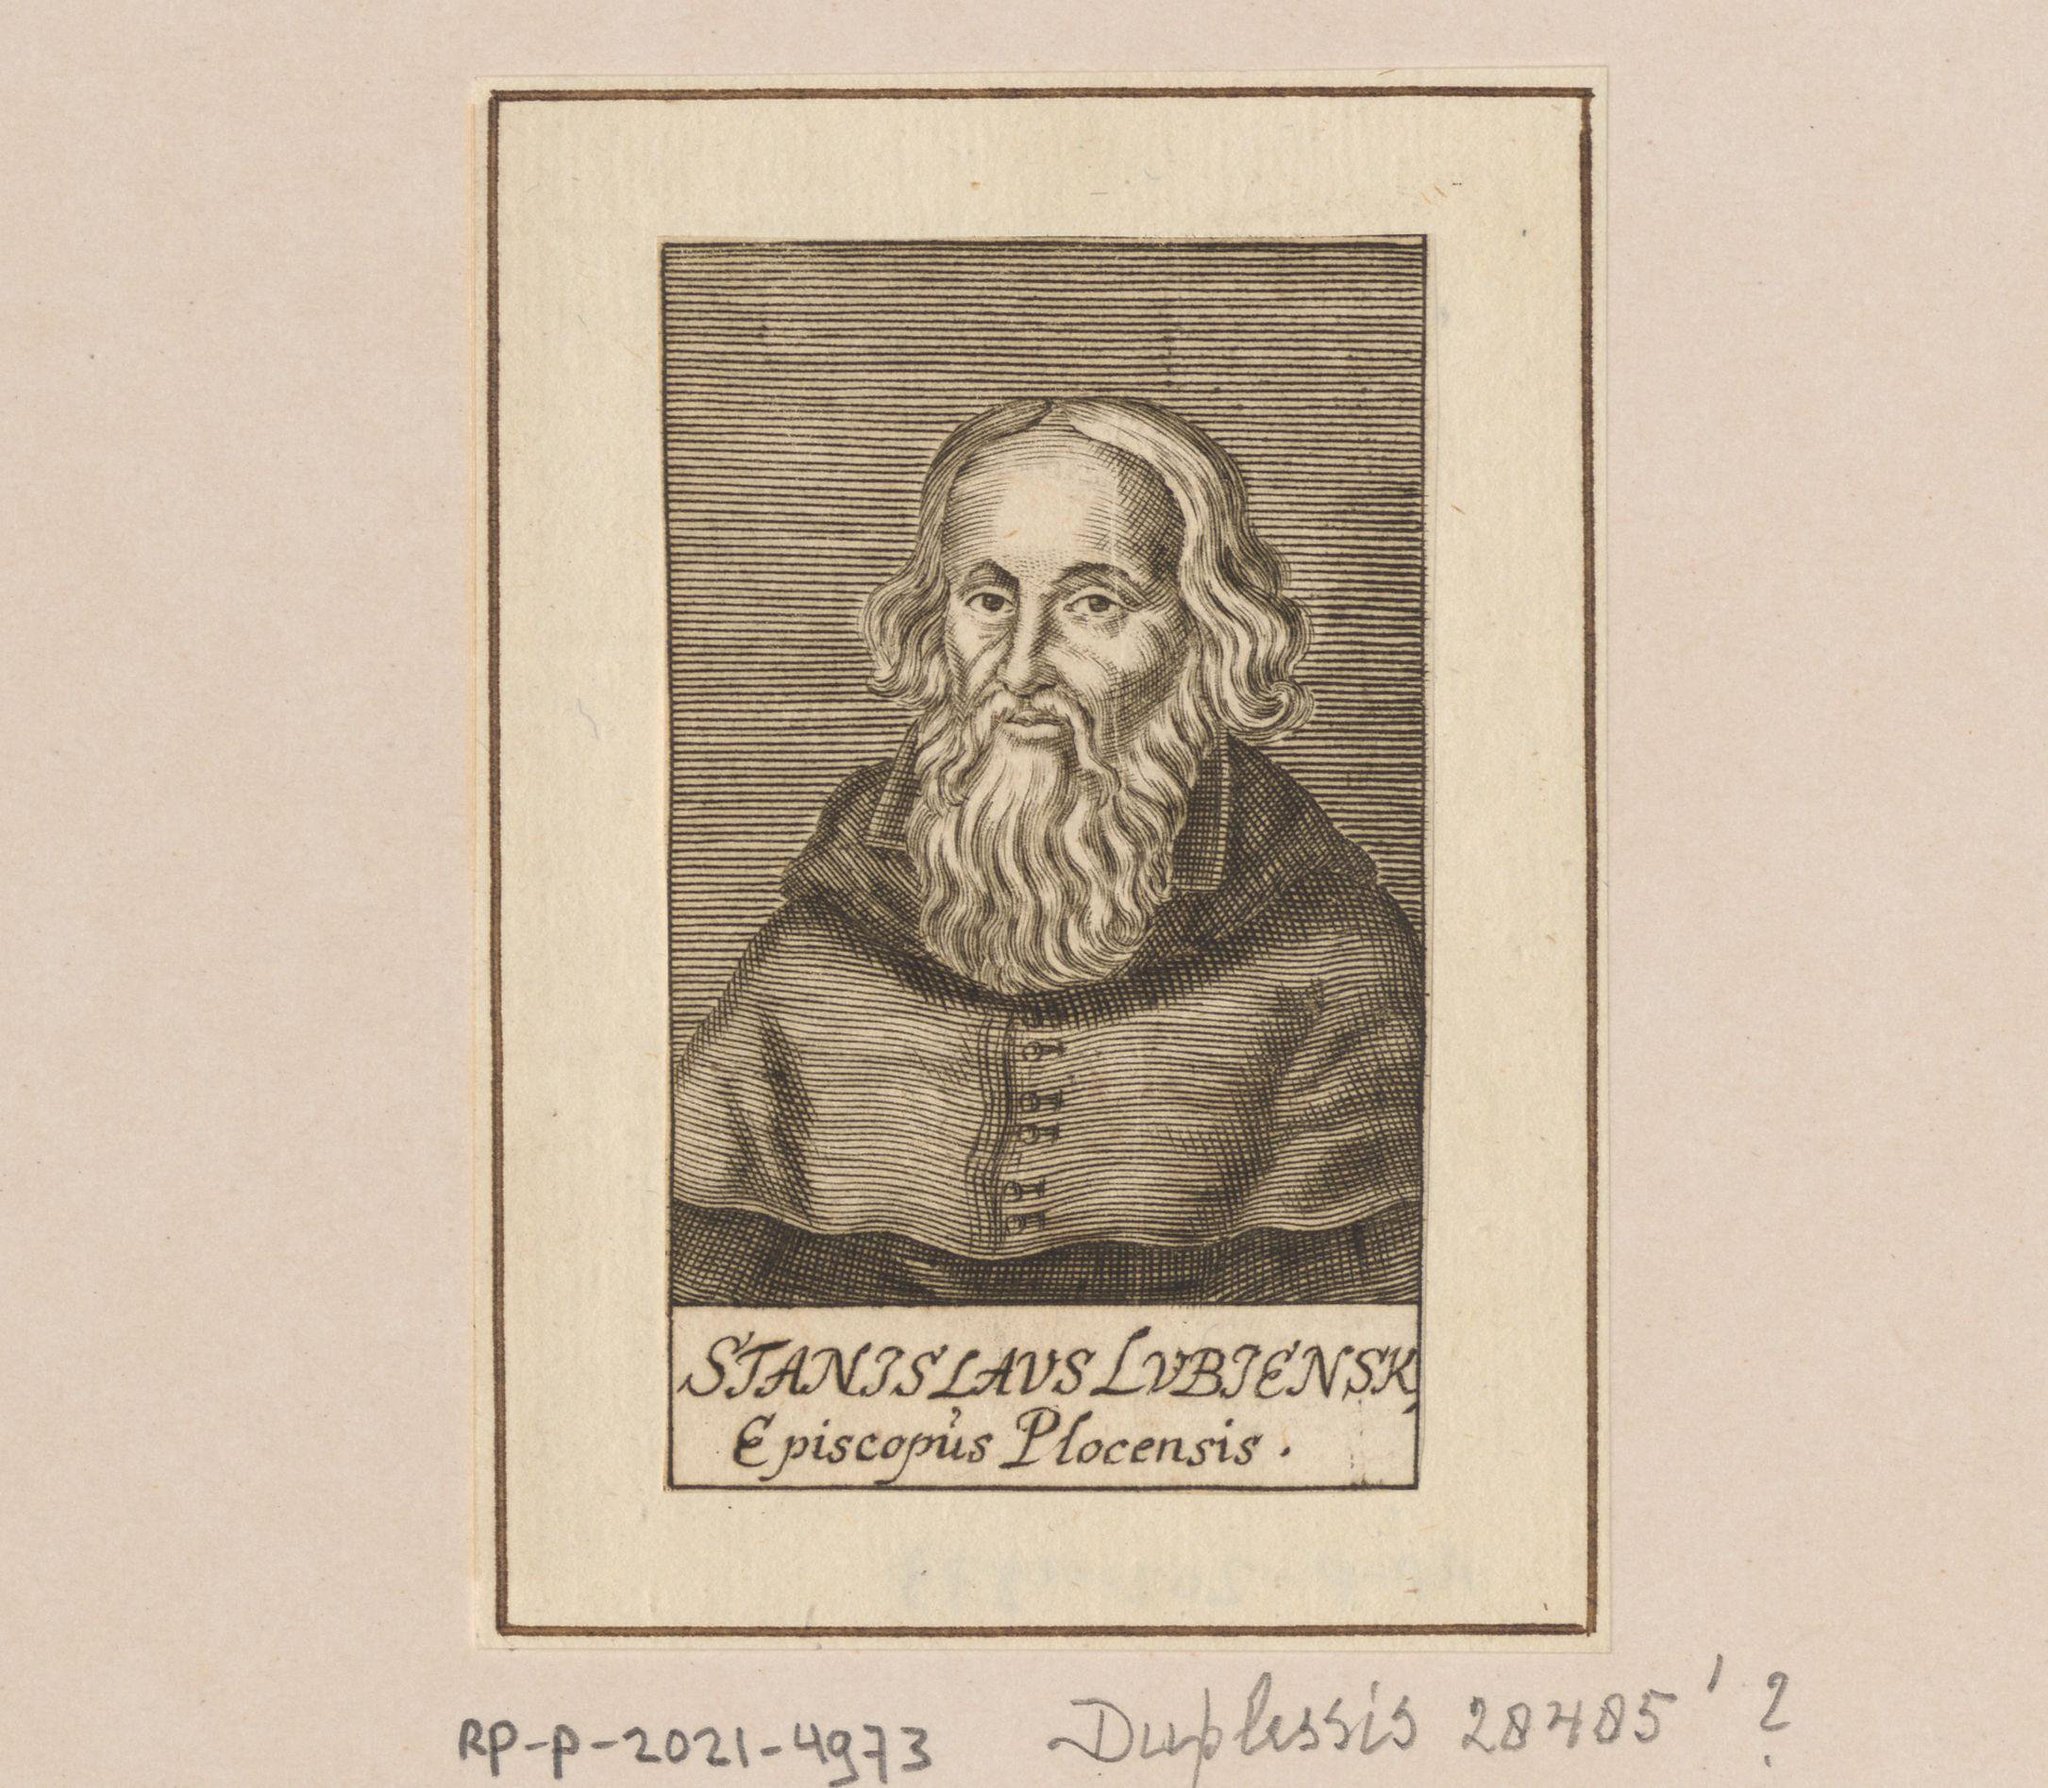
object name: book illustration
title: Portret van Stanisław Łubieński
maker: Anonymous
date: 1688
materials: paper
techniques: engraving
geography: germany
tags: archbishop, bishop, etc. (roman catholic), historical persons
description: Prent waarschijnlijk uit: Freher, Paul. Theatrum virorum eruditione clarorum. Neurenberg: Johann Hoffmann, 1688.